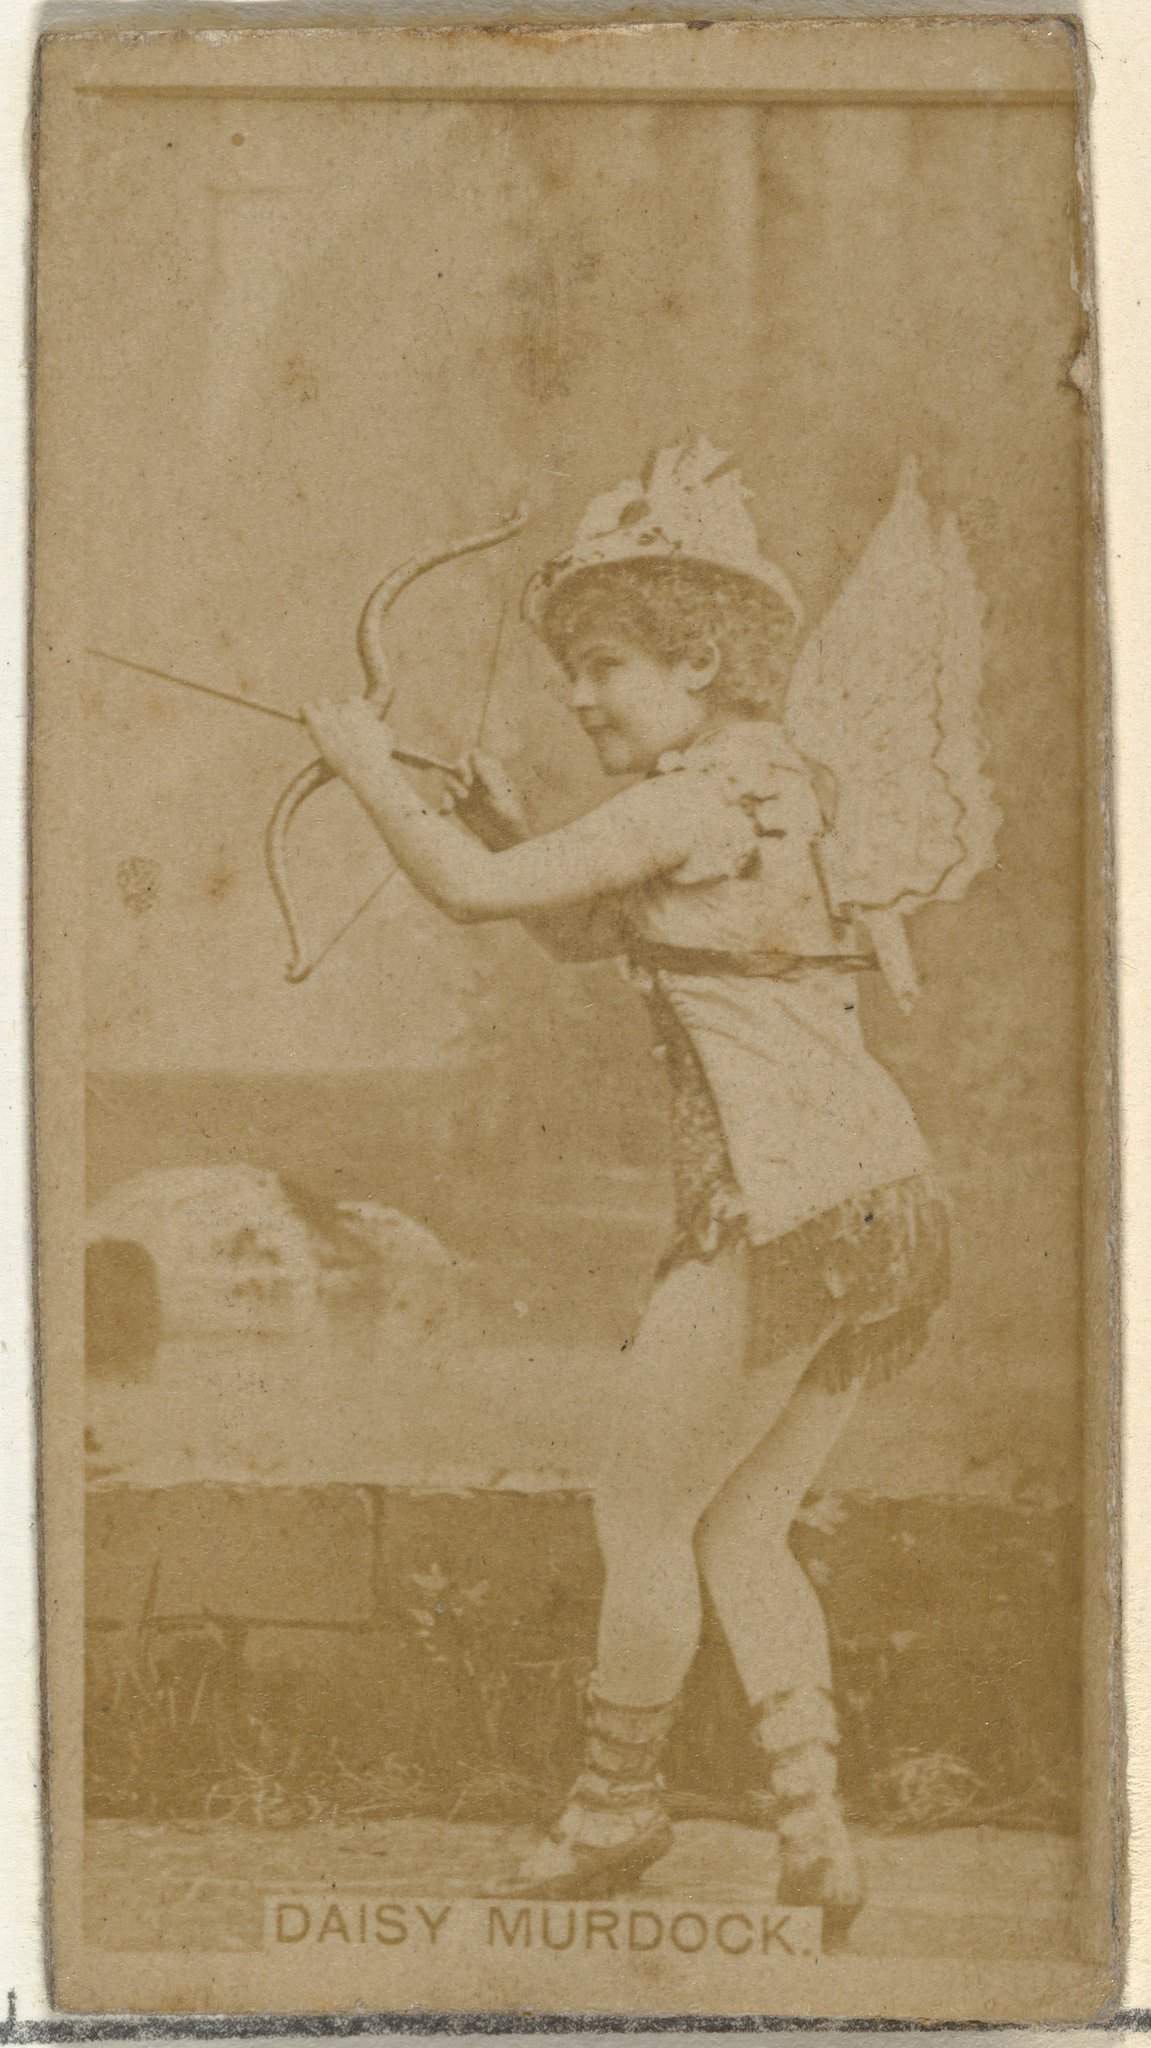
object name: photograph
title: Daisy Murdoch, from the Actors and Actresses series (N145-8) issued by Duke Sons & Co. to promote Duke Cigarettes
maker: w. duke, sons & co.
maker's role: publisher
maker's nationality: american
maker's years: 1870-1920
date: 1891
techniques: albumen silver print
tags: bow and arrow,women,actresses